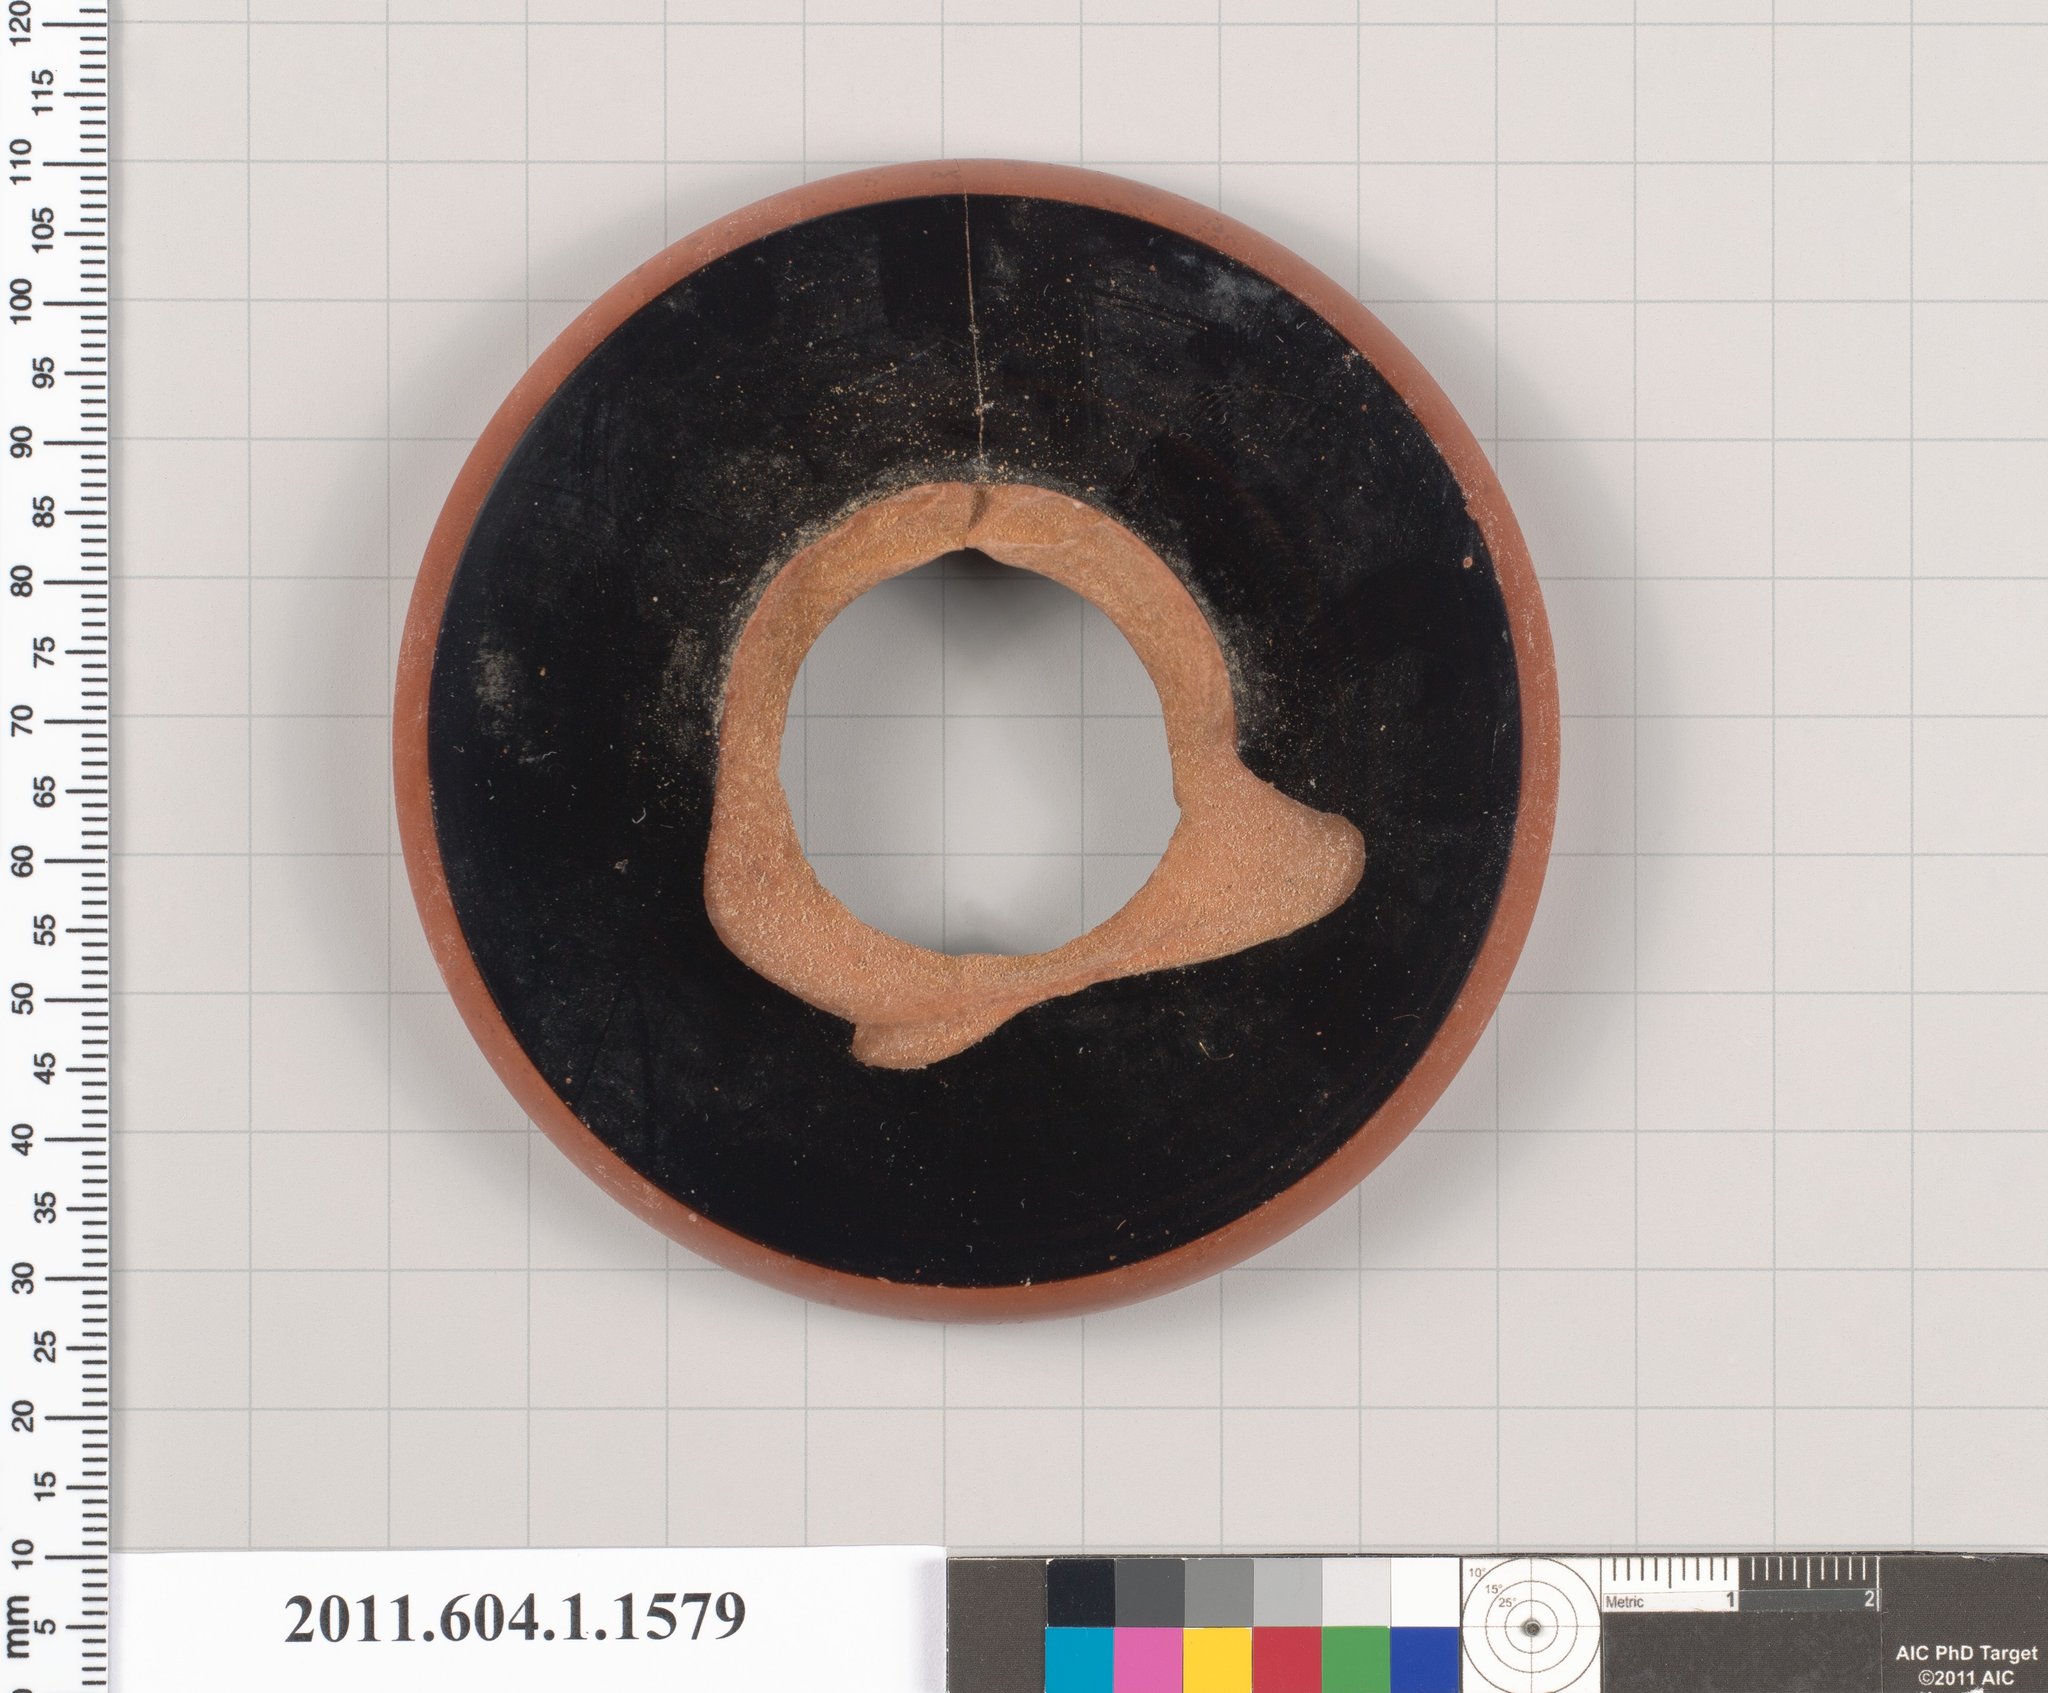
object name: kylix fragment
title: Terracotta fragment of a kylix (drinking cup)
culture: greek, attic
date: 500-401 BCE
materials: terracotta